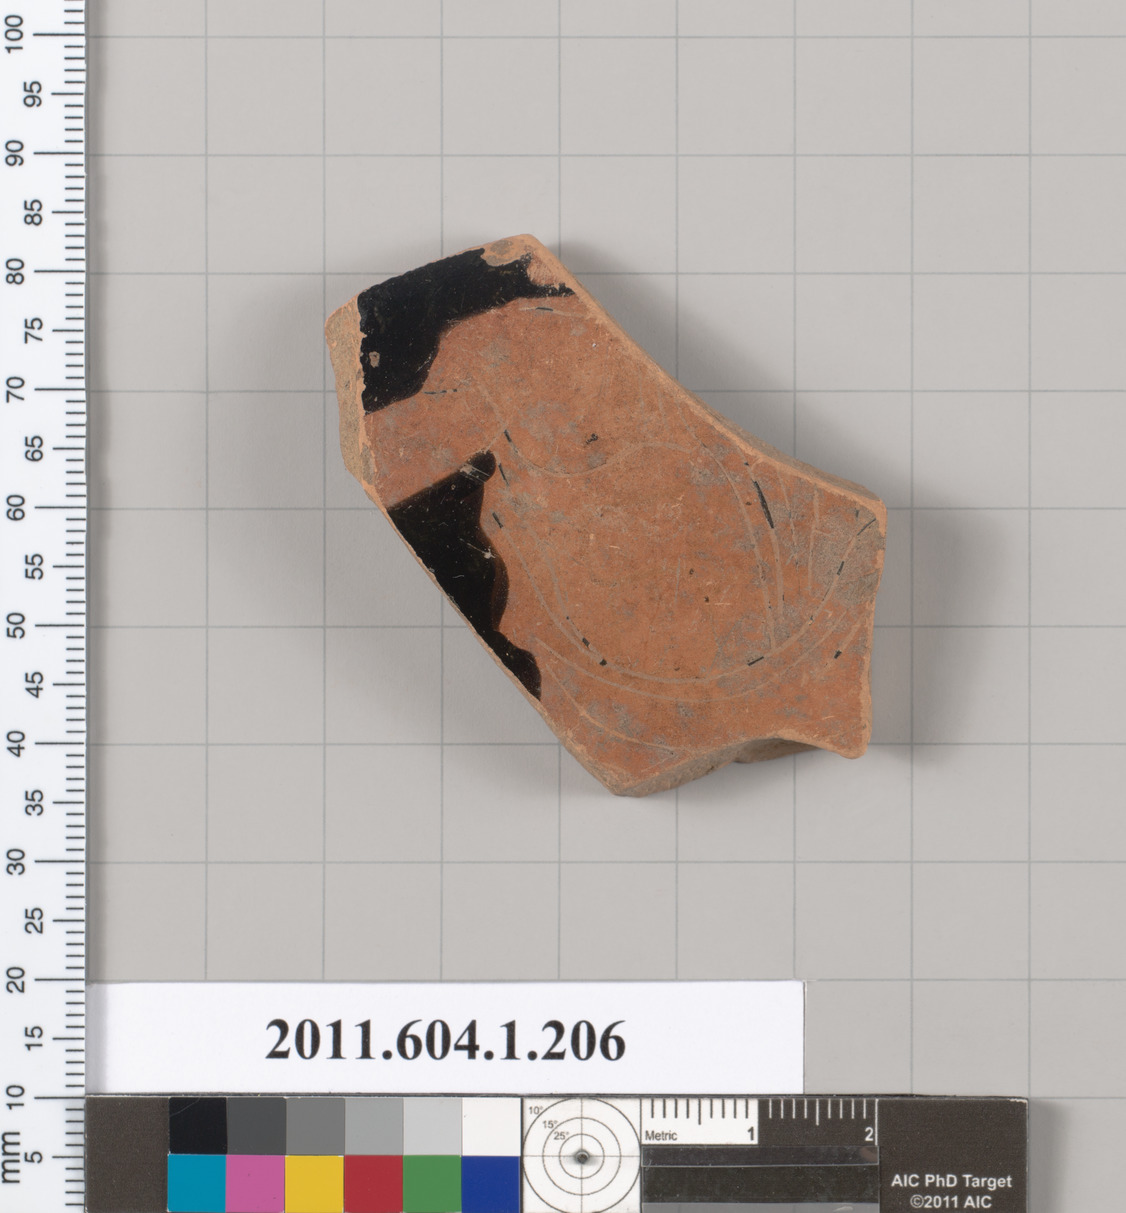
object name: kylix fragment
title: Terracotta fragment of a kylix (drinking cup)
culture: greek, attic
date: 475-451 BCE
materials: terracotta